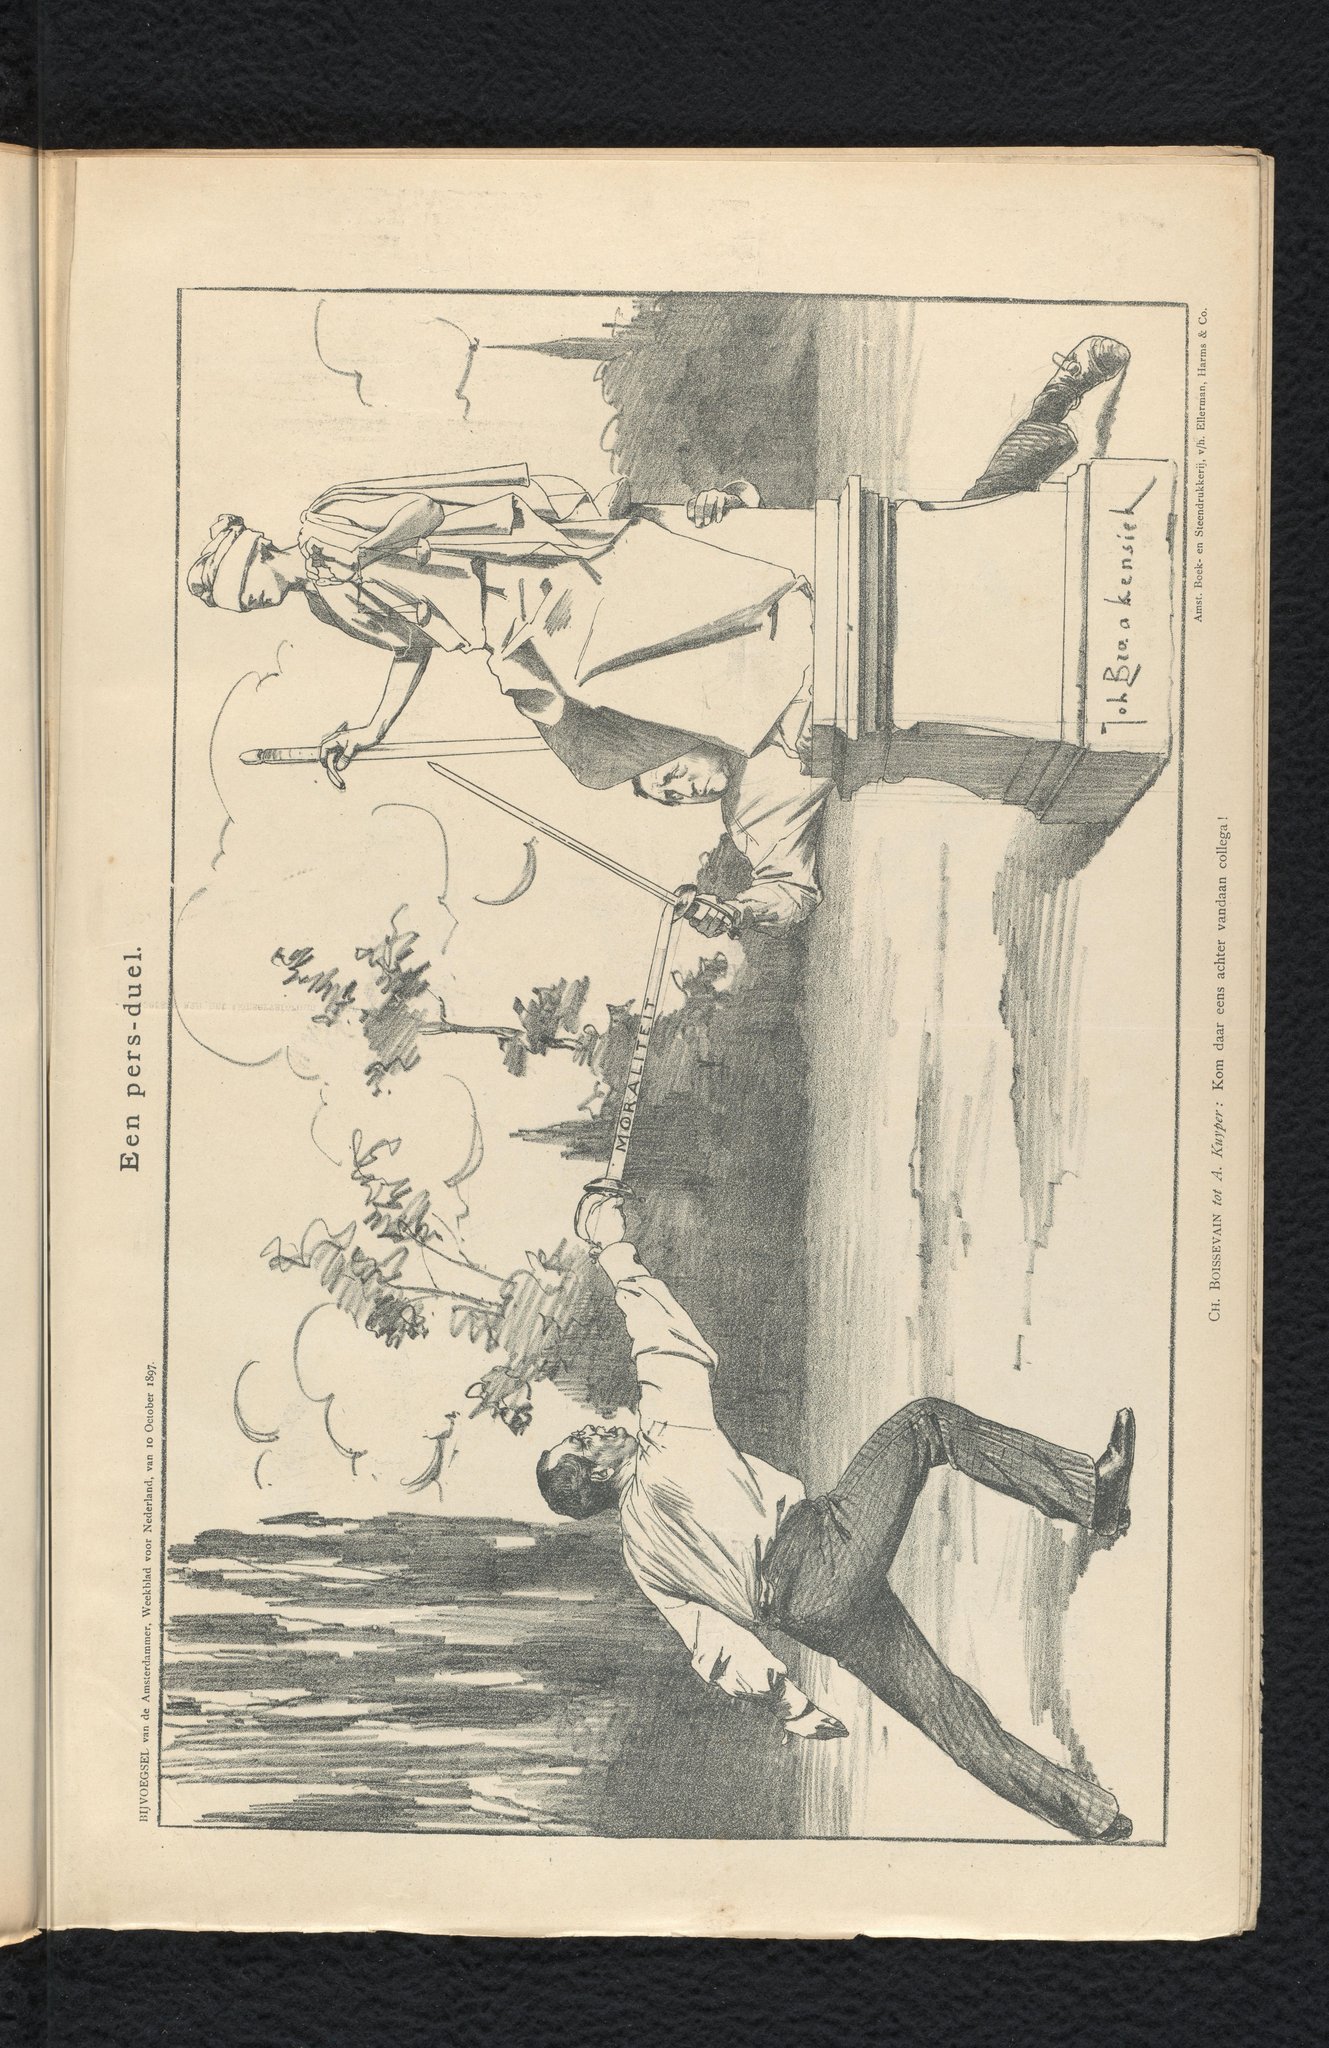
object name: cartoon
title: Een pers-duel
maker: johan braakensiek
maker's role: draughtsman, print maker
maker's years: 1858-1940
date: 1897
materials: paper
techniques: lithograph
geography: amsterdam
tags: the hague, abraham kuyper, netherlands, charles boissevain, justice, 'justitia'; 'giustitia divina' (ripa) ~ one of the four cardinal virtues, duelling, political caricatures and satires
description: De journalist Charles Boissevain duelleert met Abraham Kuyper die zich verschuilt achter een standbeeld van Justitia.